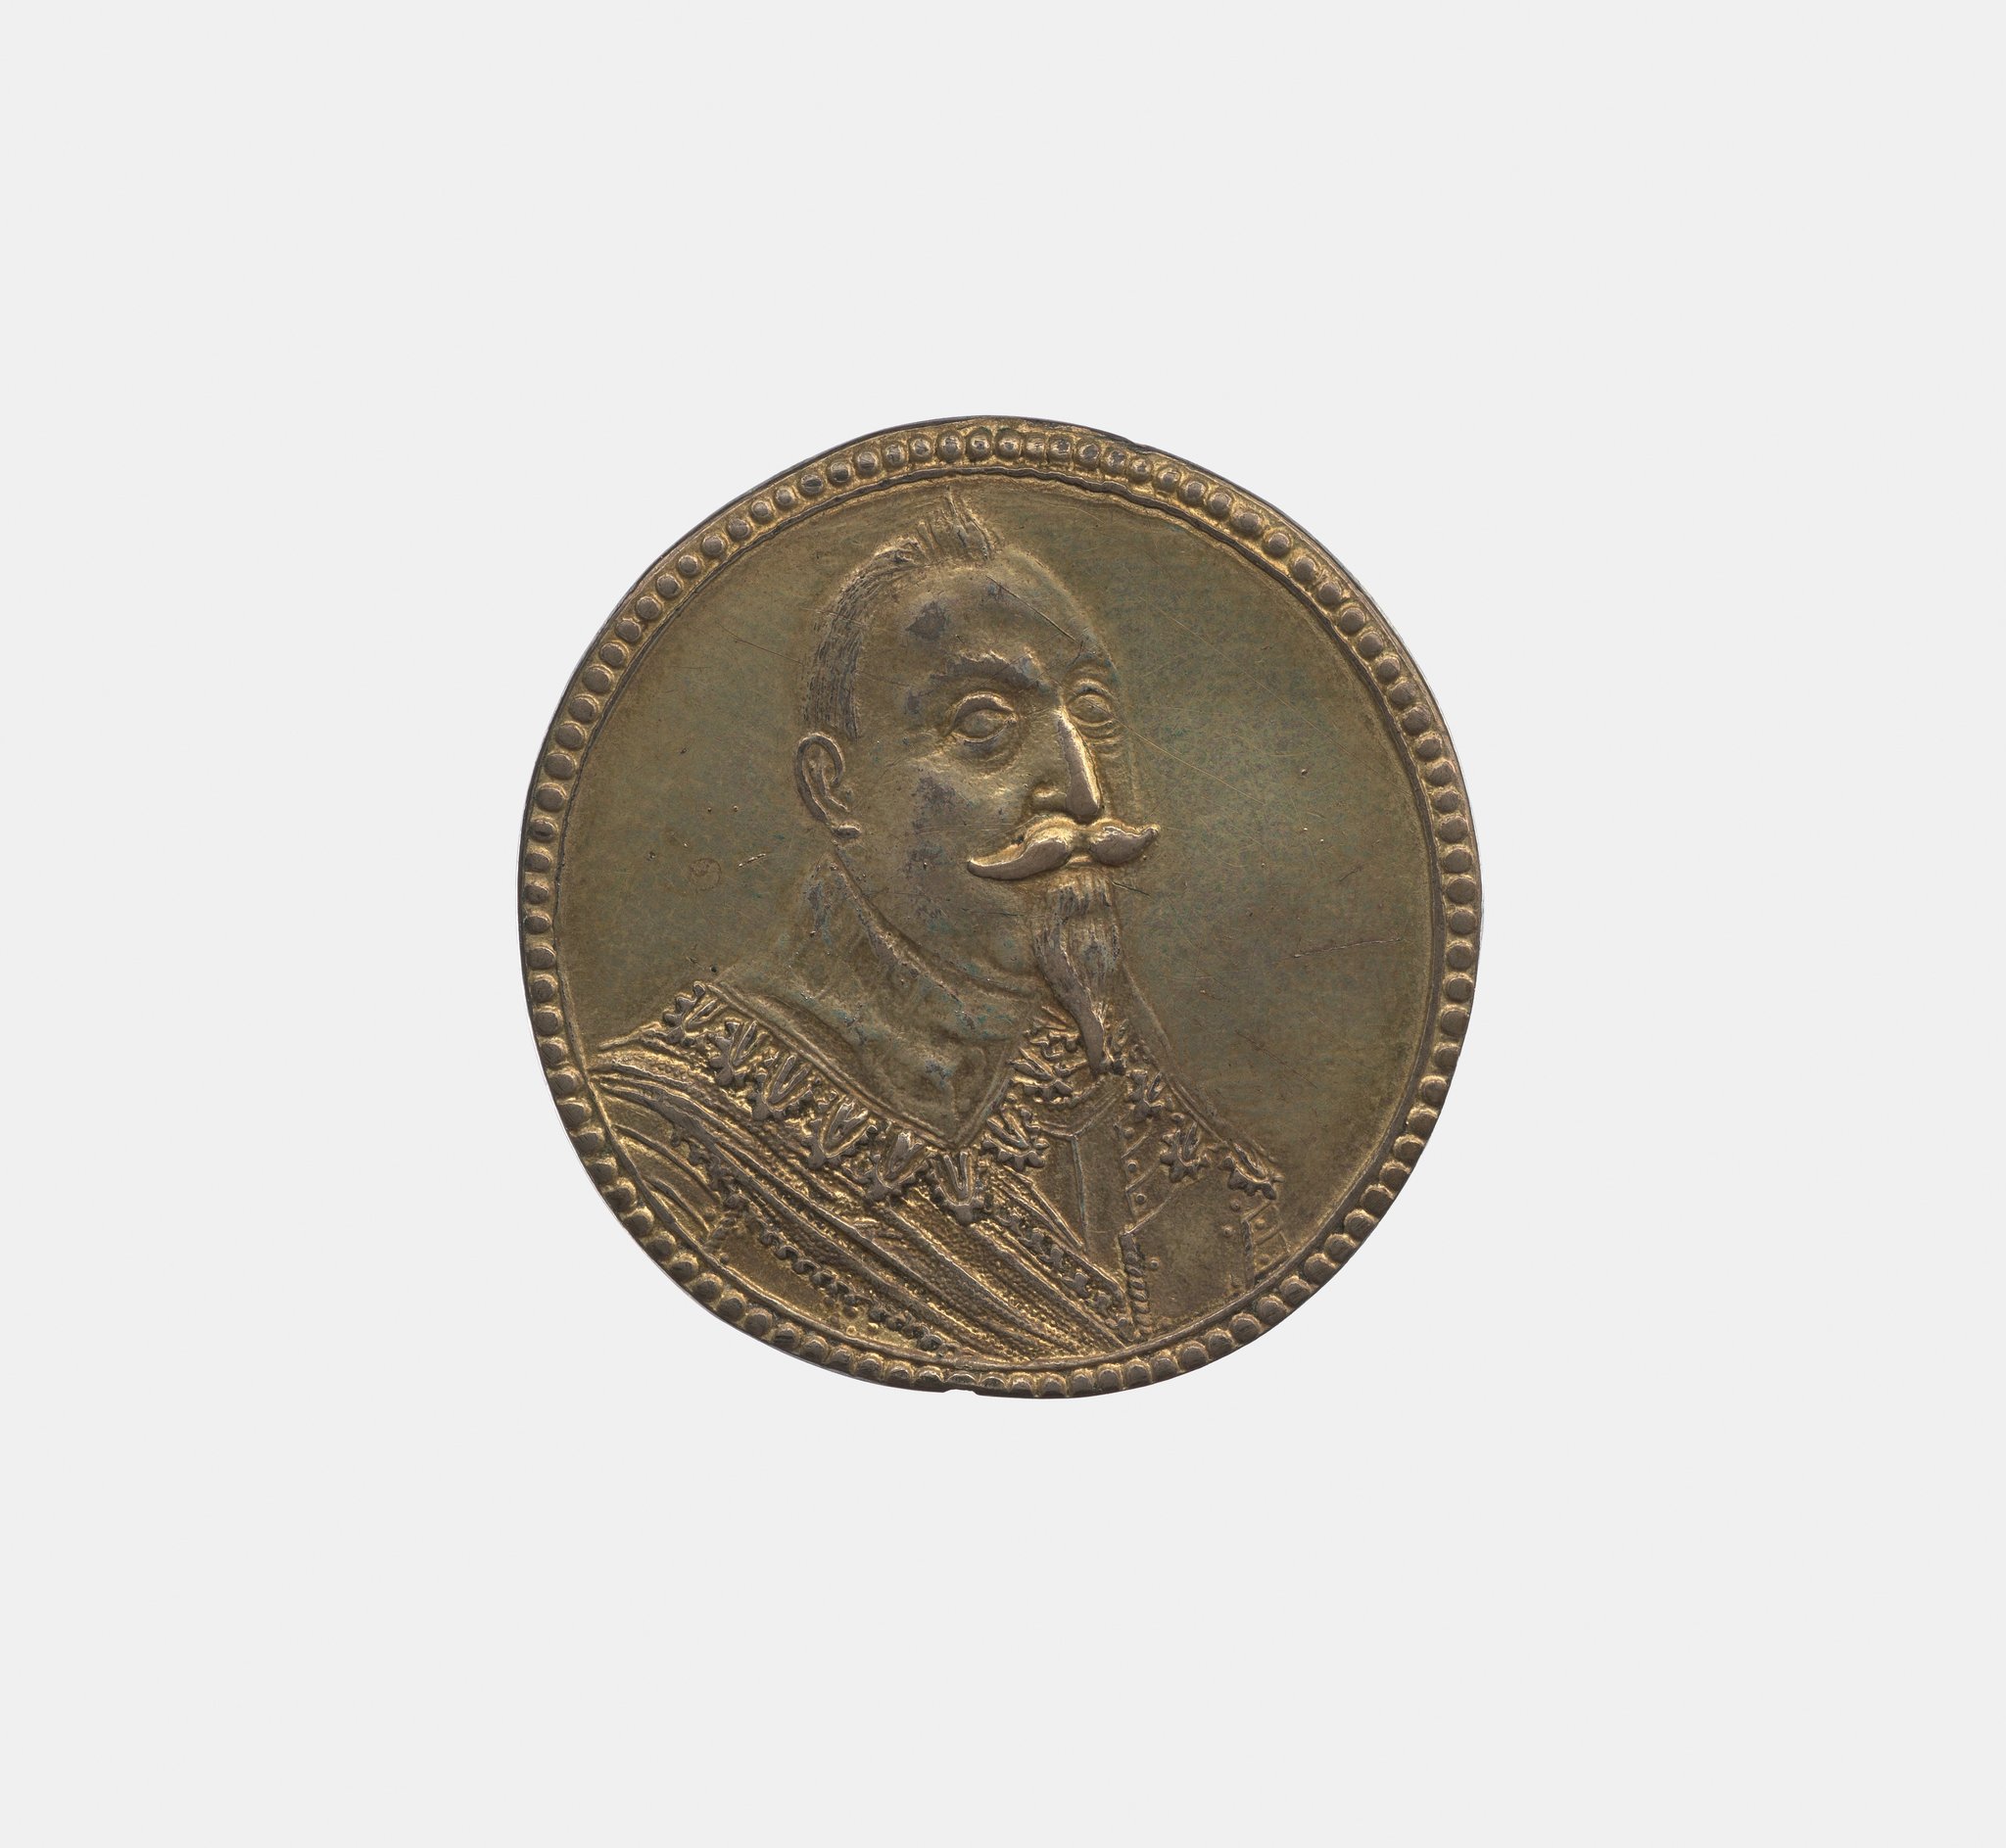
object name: medal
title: Gustavus Adolphus, King of Sweden (r. 1611–1632)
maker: Anonymous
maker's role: artist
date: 1611-1632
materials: gilt silver